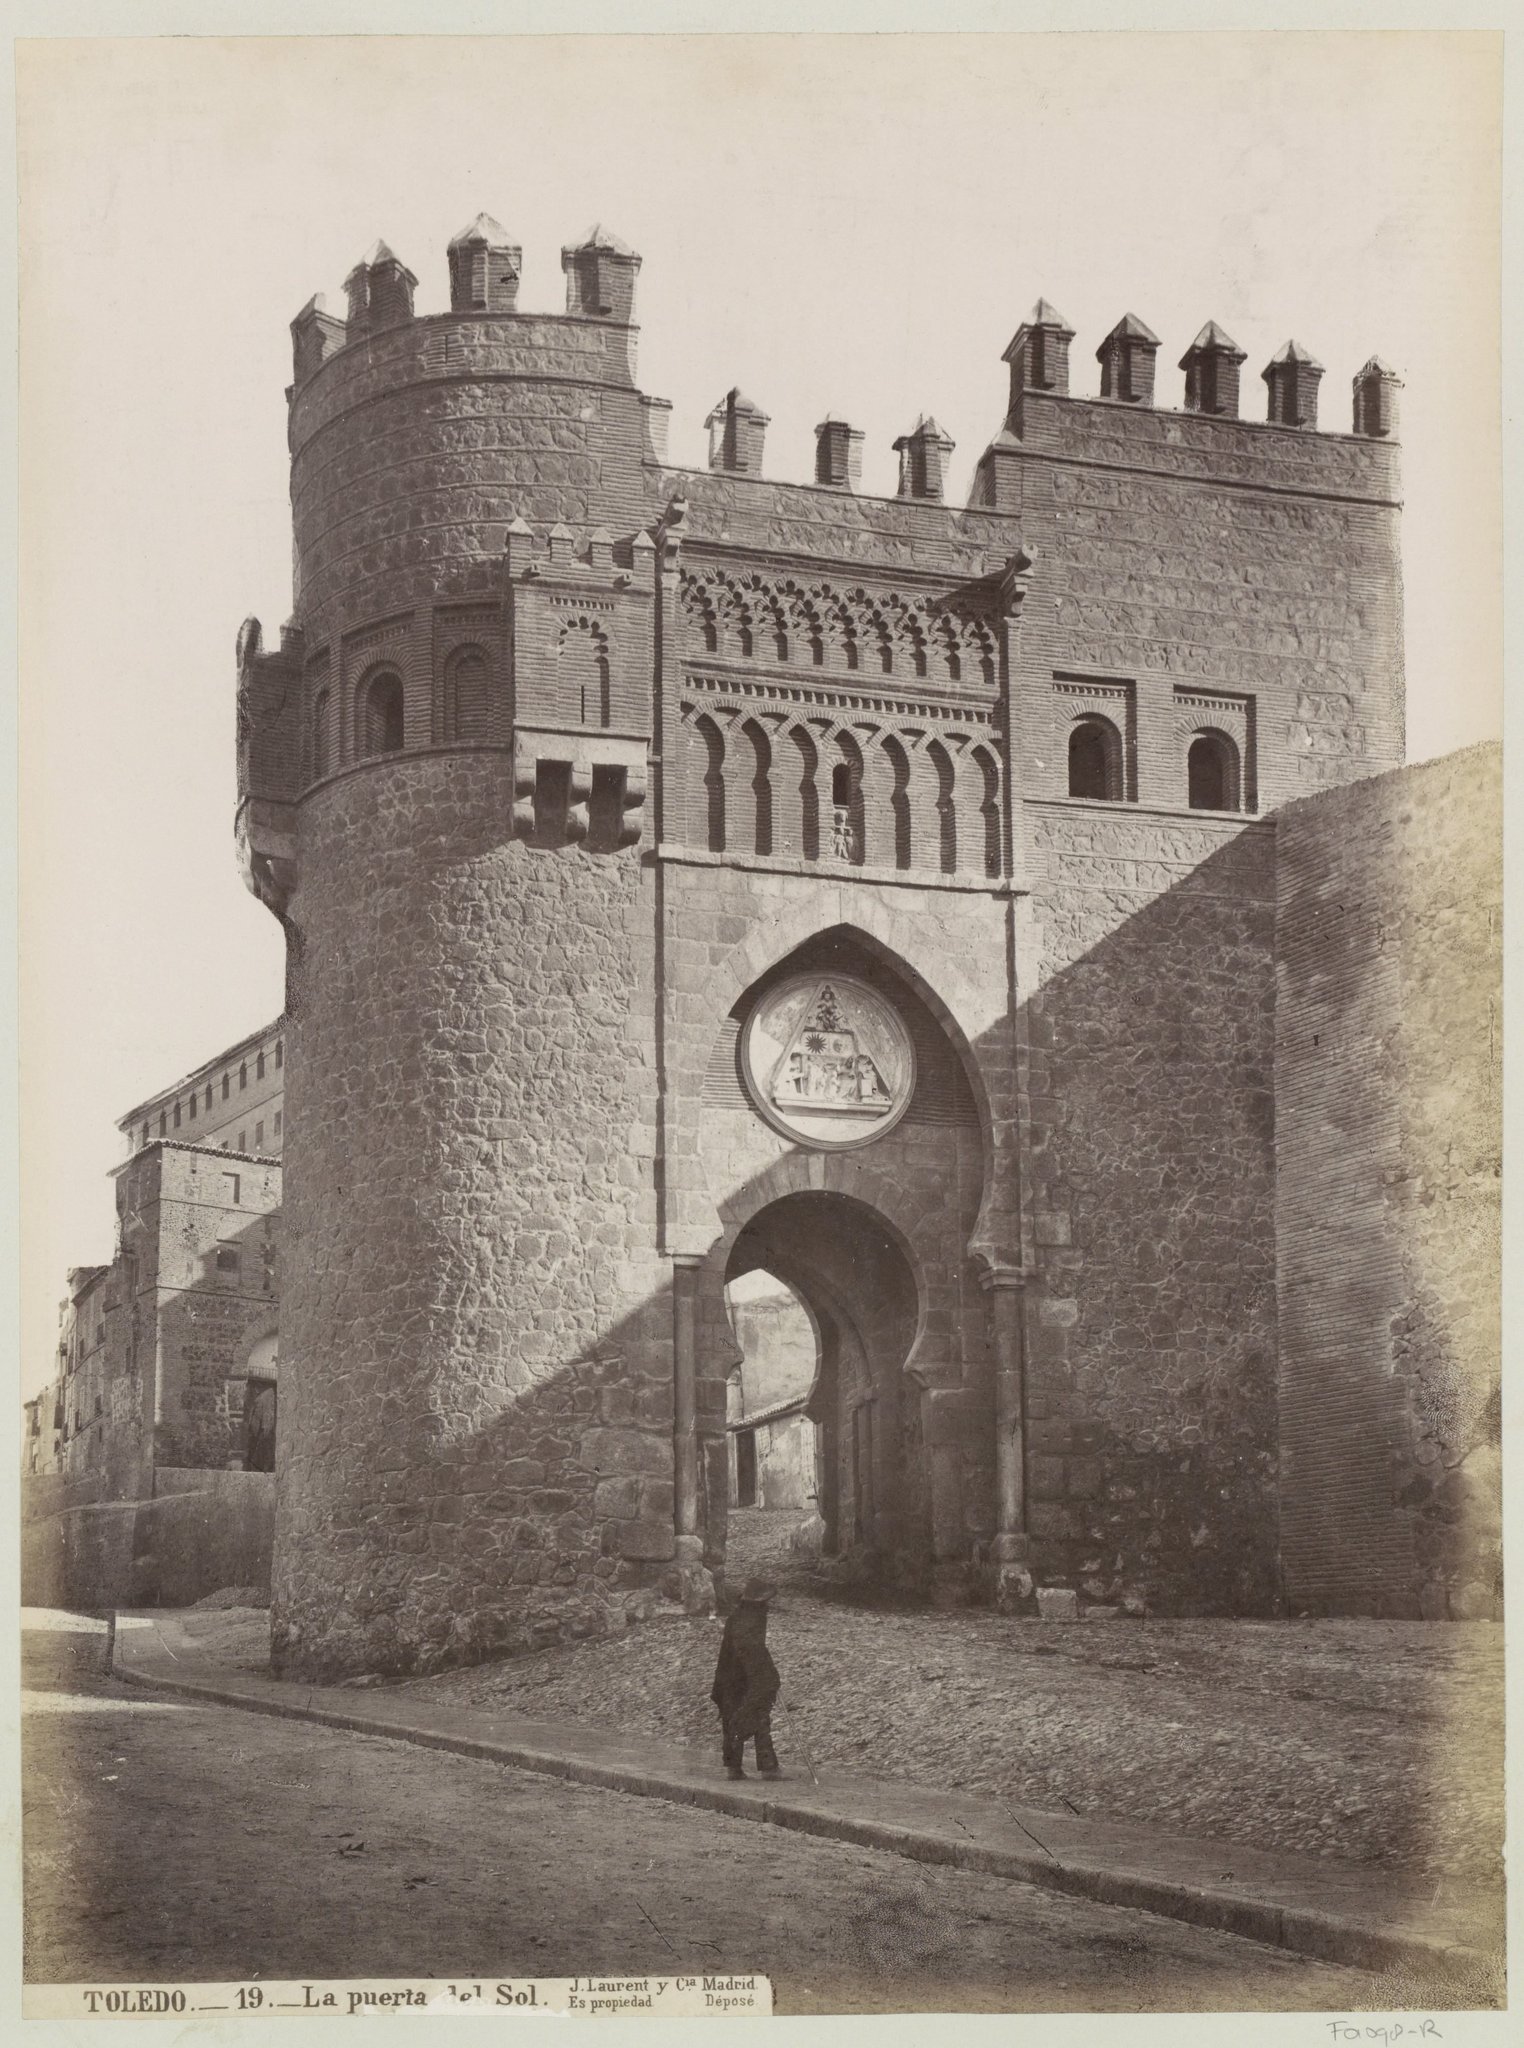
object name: photograph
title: Exterieur van de Puerta del Sol in Toledo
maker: juan laurent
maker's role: publisher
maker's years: 1816-1896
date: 1857-1880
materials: cardboard, paper, photographic support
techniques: albumen print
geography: toledo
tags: gate ~ fortified city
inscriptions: negative number: ‘19’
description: Onderdeel van Reisalbum met foto's van bezienswaardigheden in Spanje en Marokko.